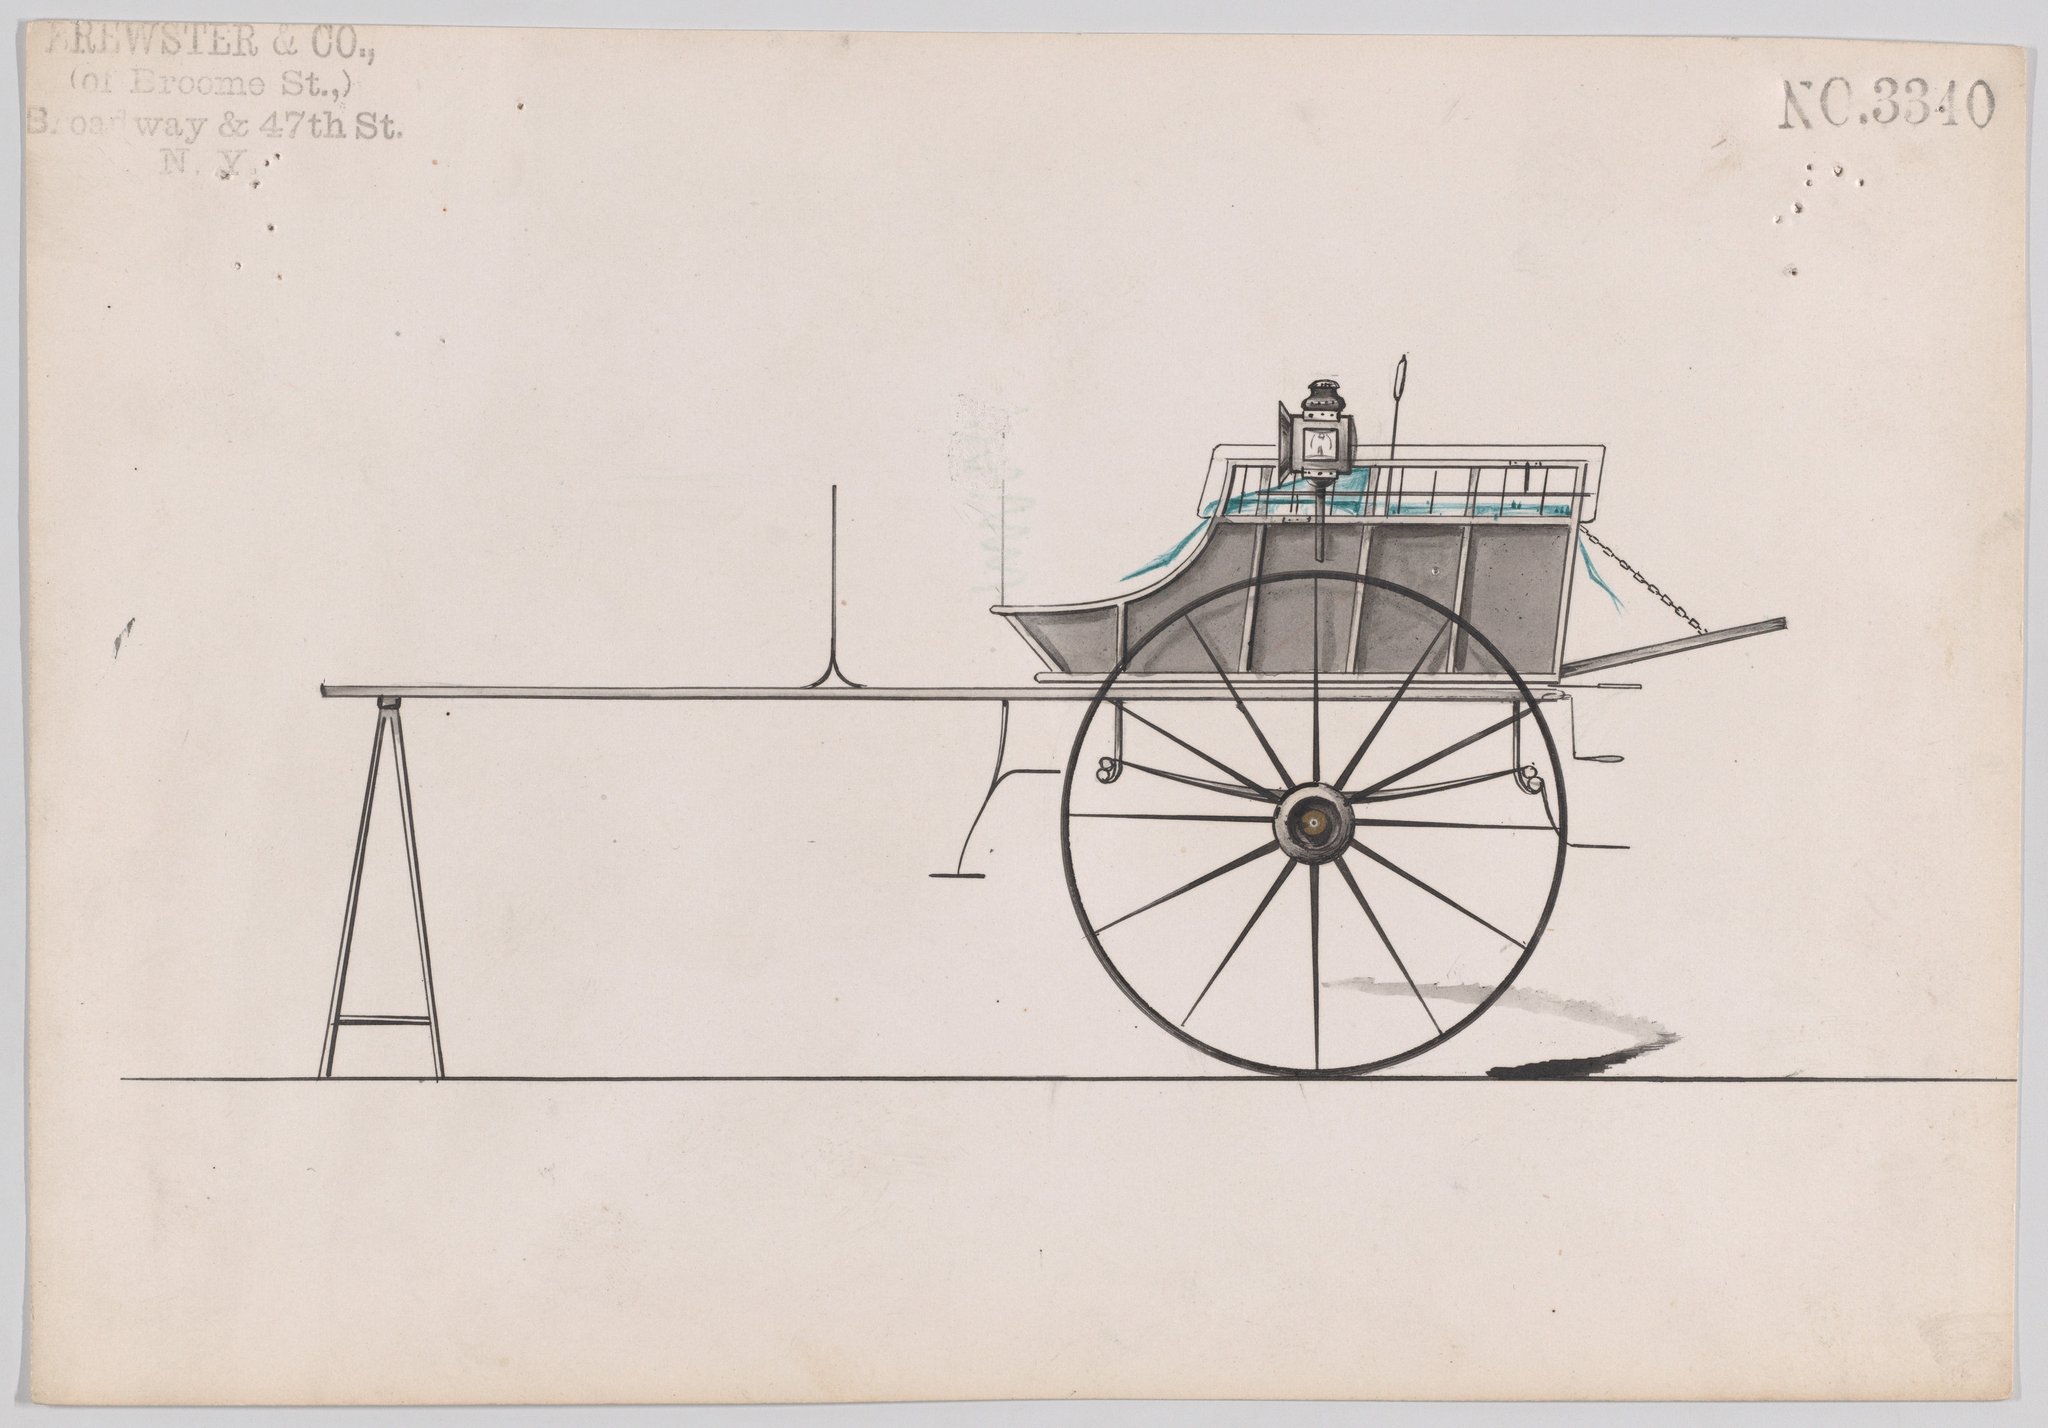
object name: drawing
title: White Chapel Cart #3340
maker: brewster & co.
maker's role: manufacturer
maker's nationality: american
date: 1877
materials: gouache, gum arabic, ink, watercolor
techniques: pen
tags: carriages